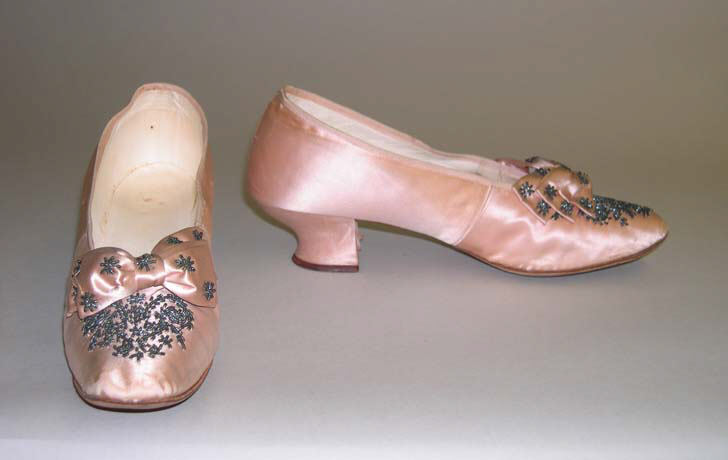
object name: evening pump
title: Evening pumps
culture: american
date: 1885-1895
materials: cotton, leather, silk, steel